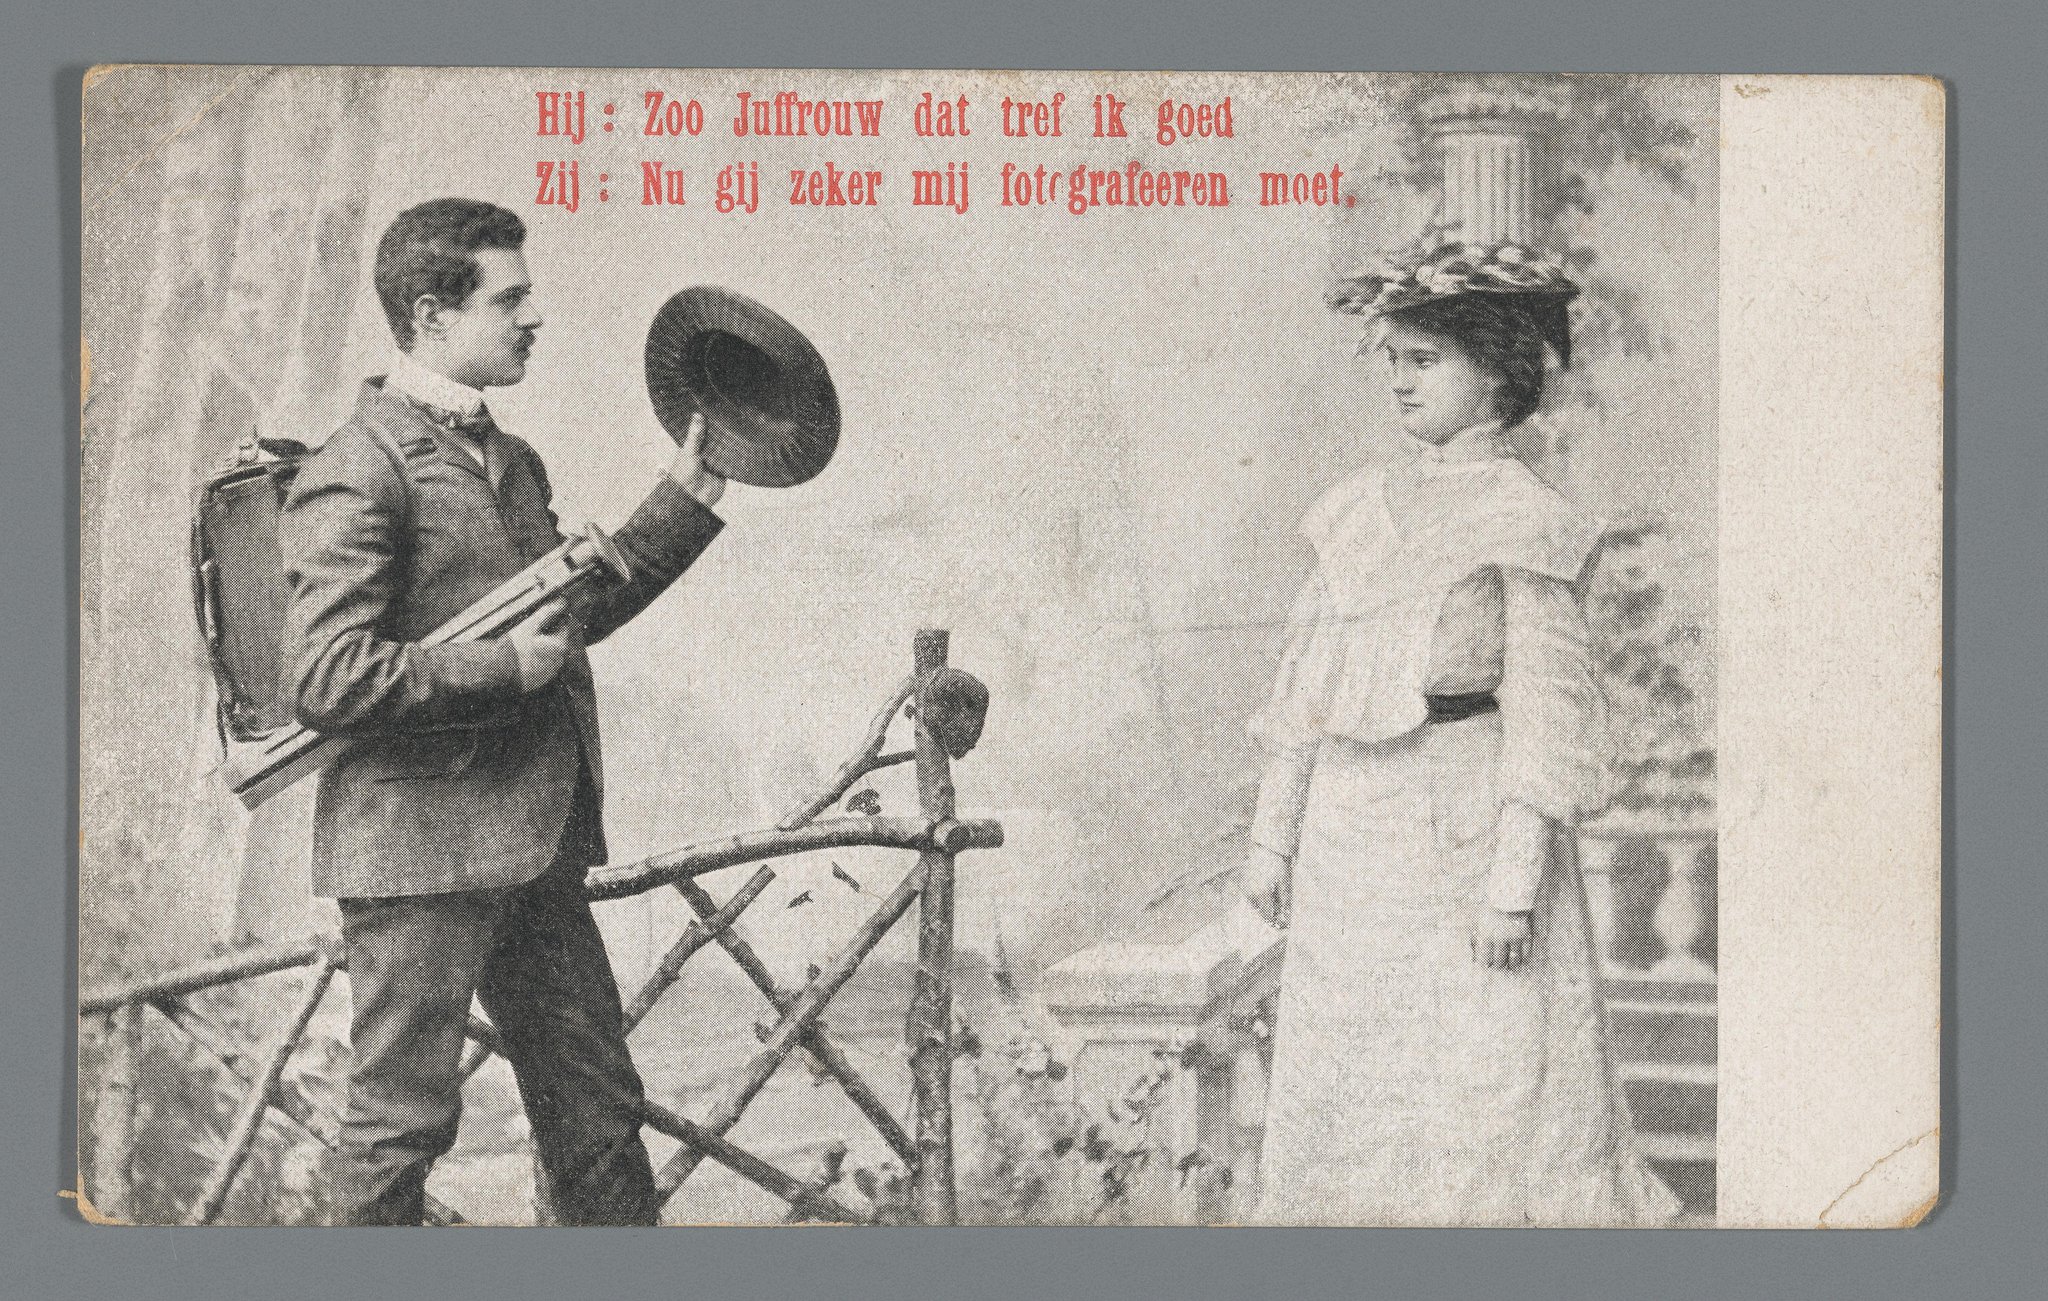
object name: photomechanical print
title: Fotograaf met statief onder de arm neemt zijn hoed af voor het model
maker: Anonymous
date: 1892-1905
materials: cardboard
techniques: autotype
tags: studio ~ photographer, historical persons not known by name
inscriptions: inscription: ‘Brefkort - Tarjetas postale/ Carte postale - Levelezö-lap - Cartolina postale/ Karta korespondencyjna - [...]/ Dopisnice - Postkarte - Briefkaart.’, inscription: ‘Hij: Zoo Juffrouw dat tref ik goed/ Zij: Nu gij zeker mij fotografeeren moet.’, factory mark: ‘EXCELSIOR 87/7’